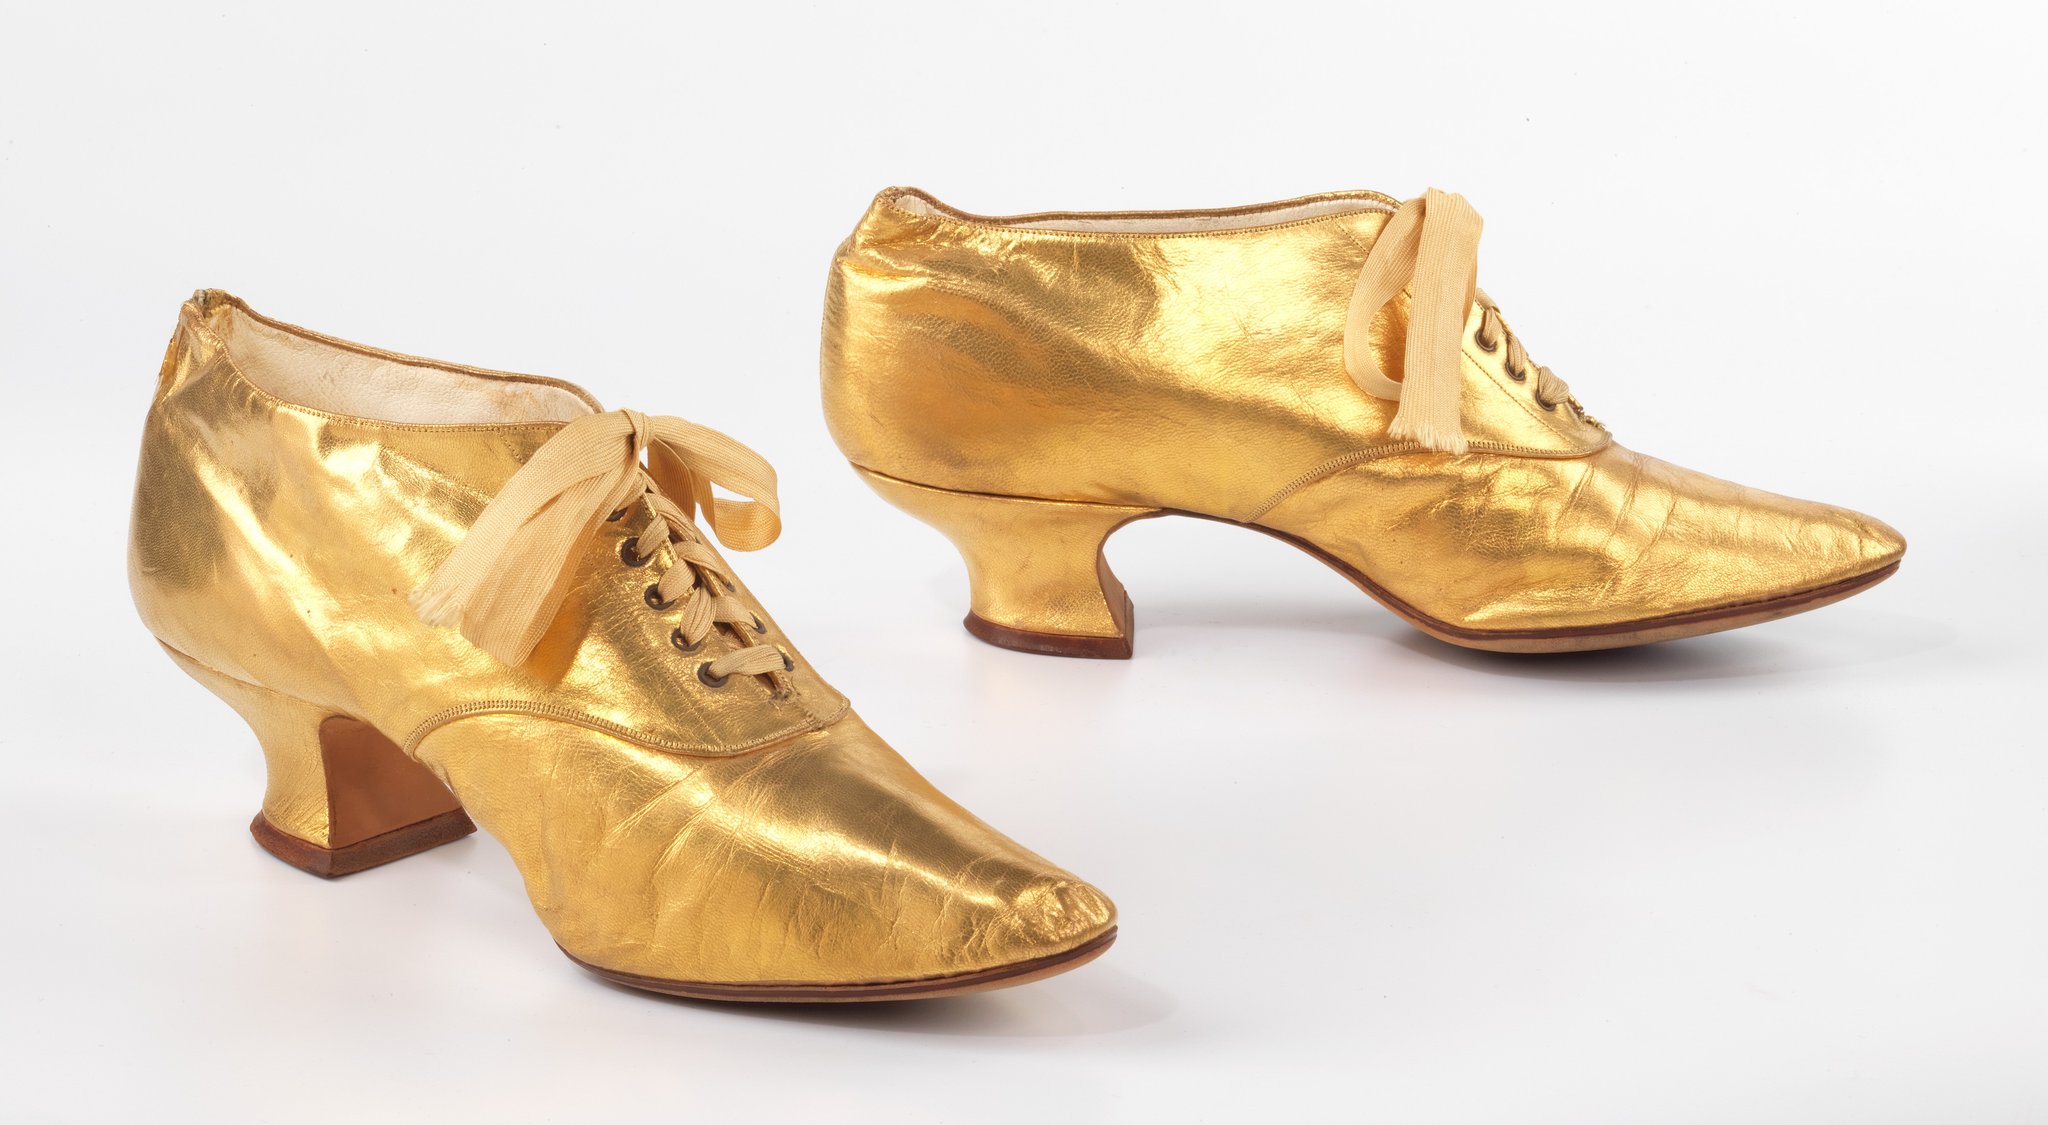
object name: evening oxford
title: Evening oxfords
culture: american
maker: alfred j. cammeyer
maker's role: department store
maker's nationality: american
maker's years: 1875-1940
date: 1891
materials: leather